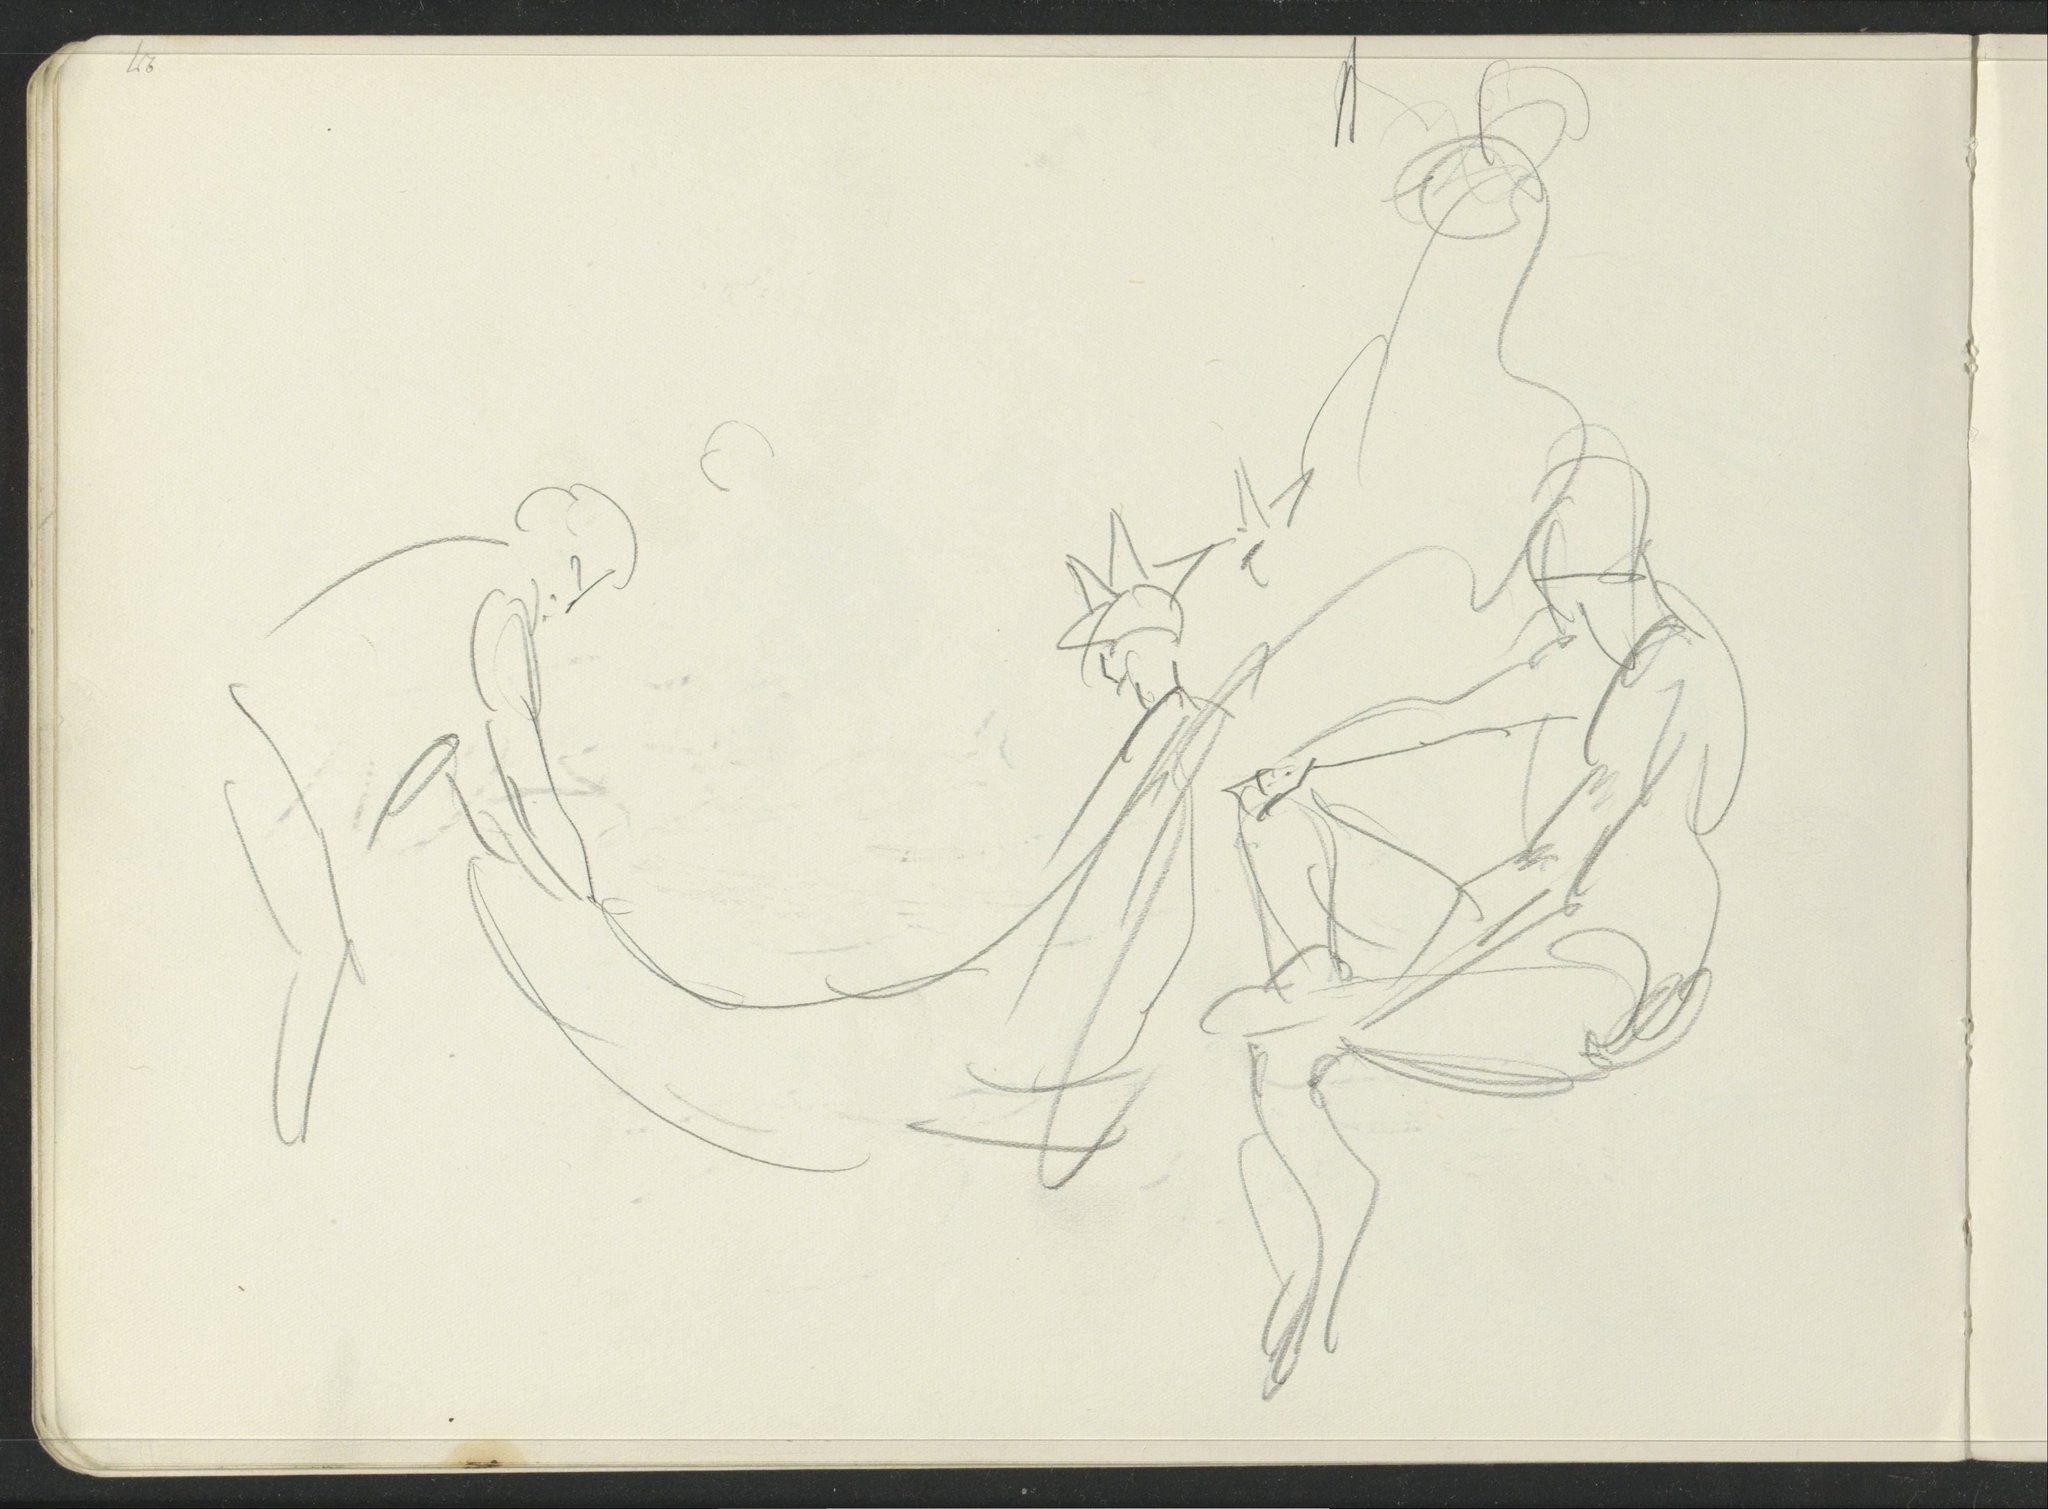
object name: sketchbook leaf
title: Figuurstudies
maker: isaac israels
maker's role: draughtsman, painter, print maker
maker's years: 1865-1934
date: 1915-1934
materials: paper, pencil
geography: the hague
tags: postures of the human figure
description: Onder andere een zittende figuur en vooroverbuigende vrouw met een stuk stof in haar handen. Blad 18 verso uit schetsboek XV met 22 bladen.